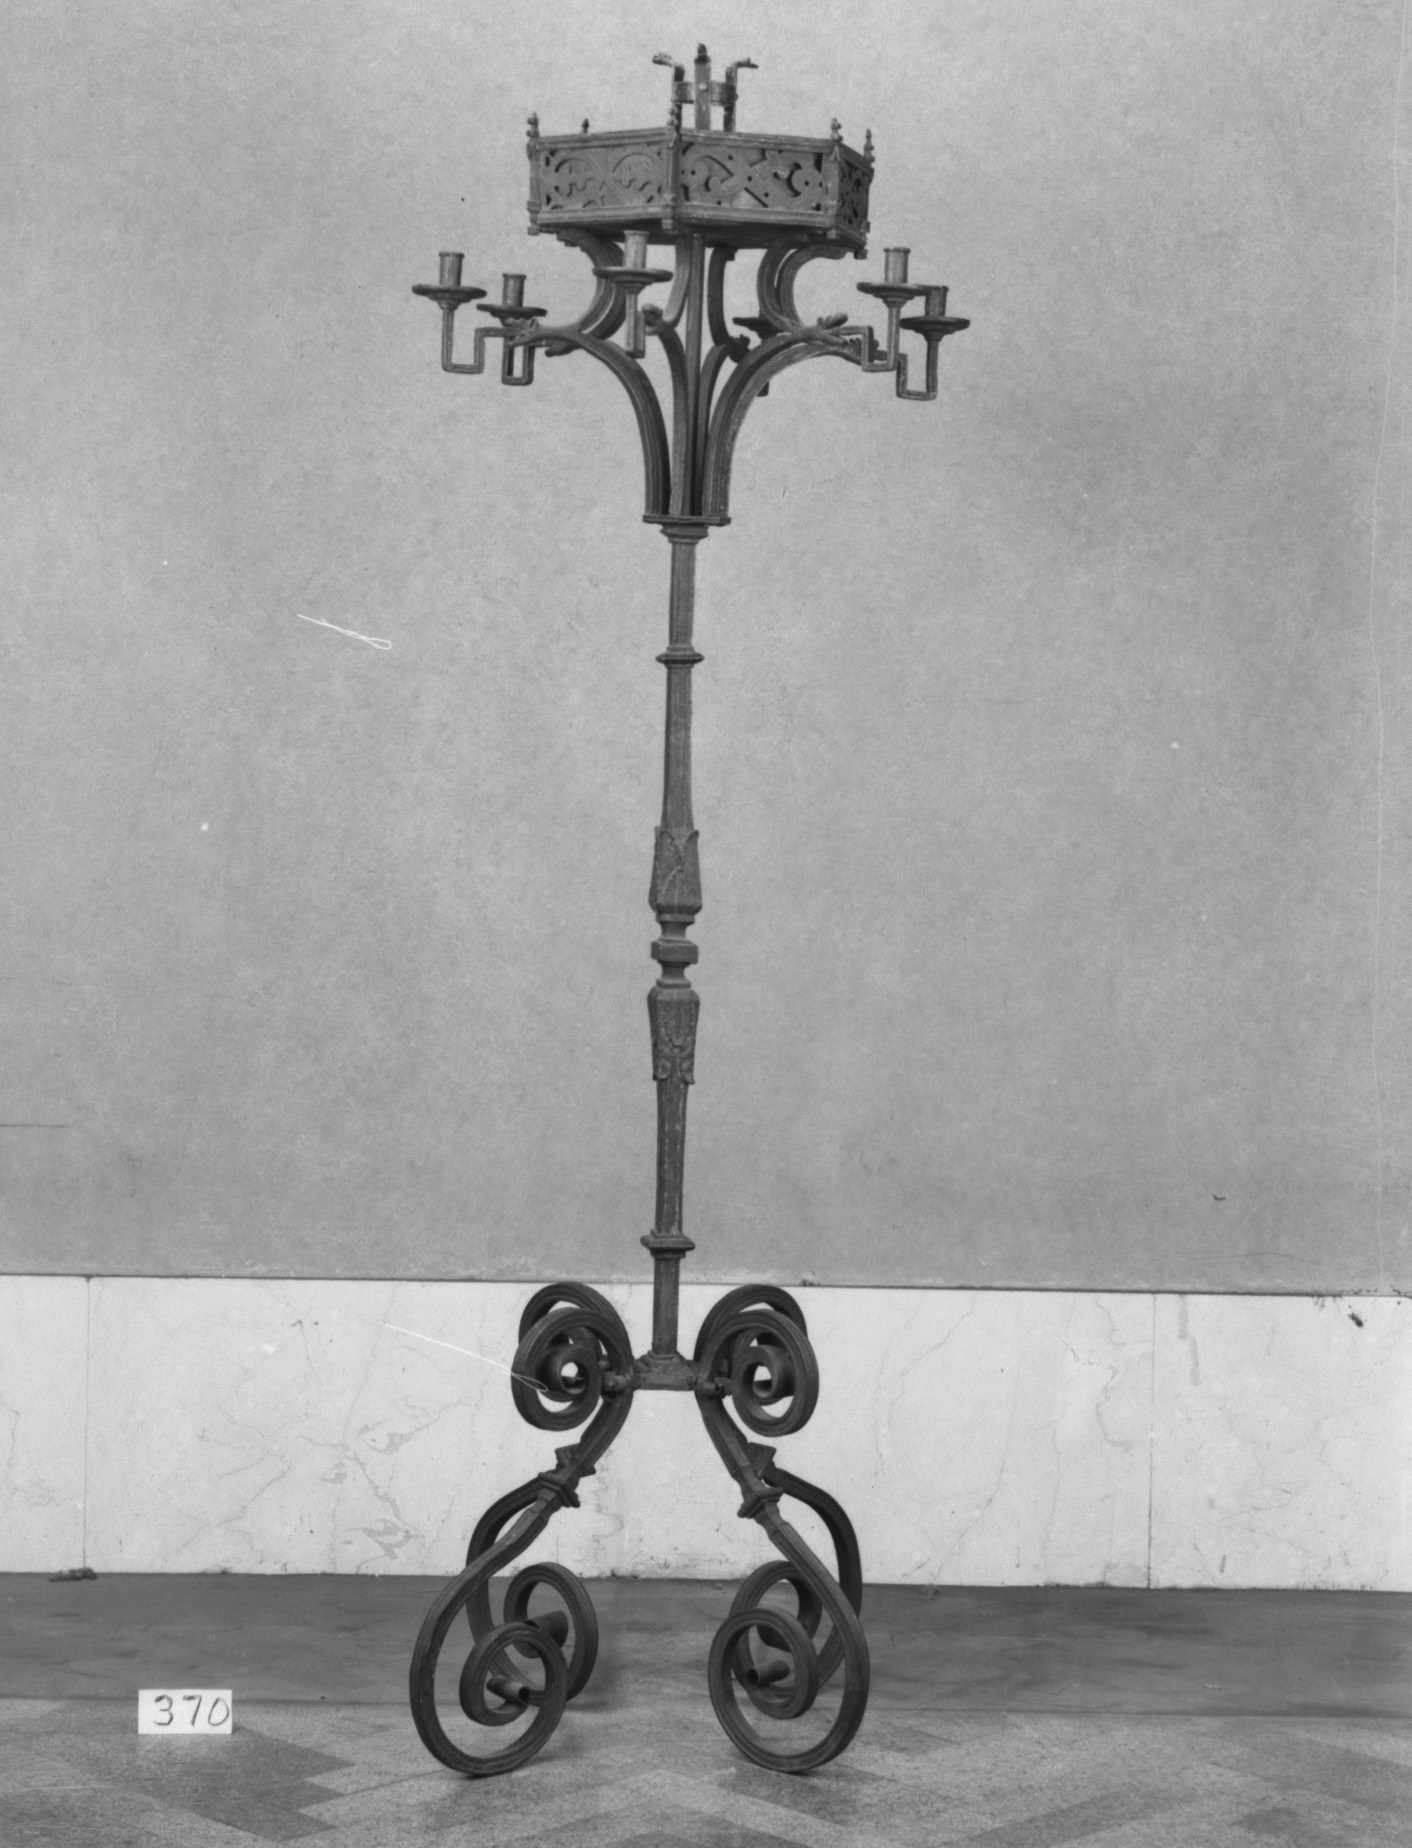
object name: candelabrum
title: Pair of standing candelabra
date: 1501-1600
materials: iron